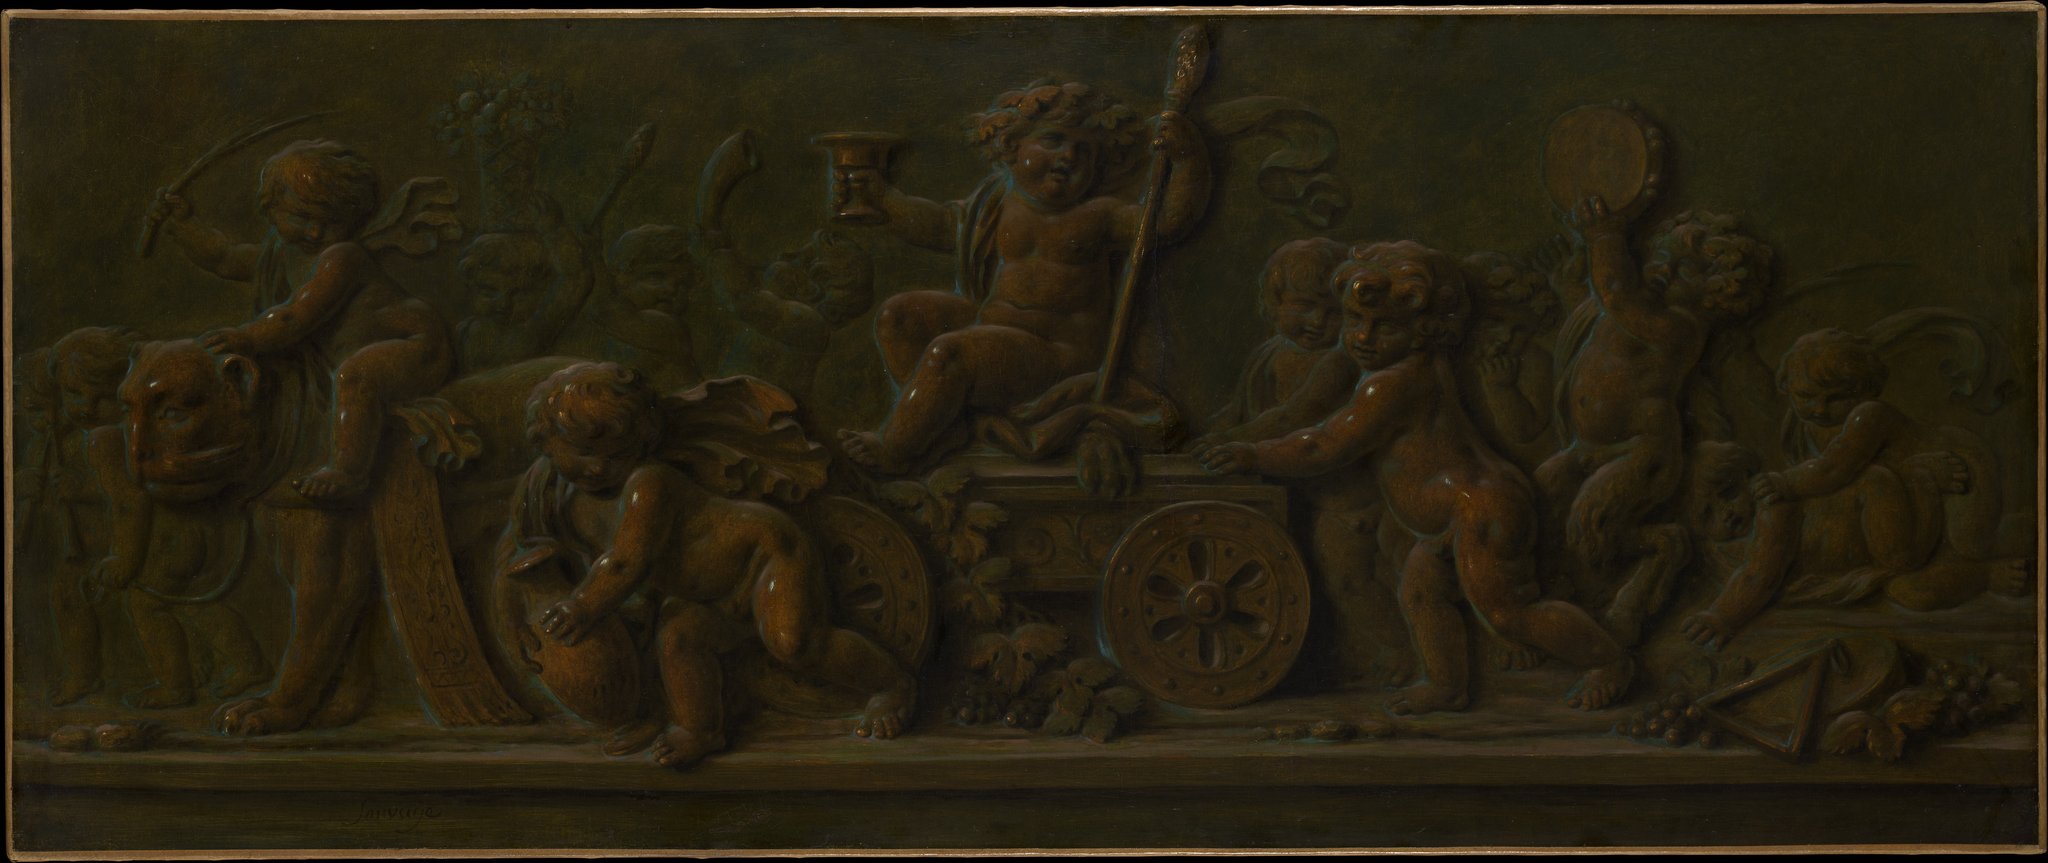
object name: painting, grisaille overdoor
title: The Triumph of Bacchus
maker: piat joseph sauvage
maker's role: artist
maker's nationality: flemish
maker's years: 1744-1818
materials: canvas, oil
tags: putti,bacchus,chariots